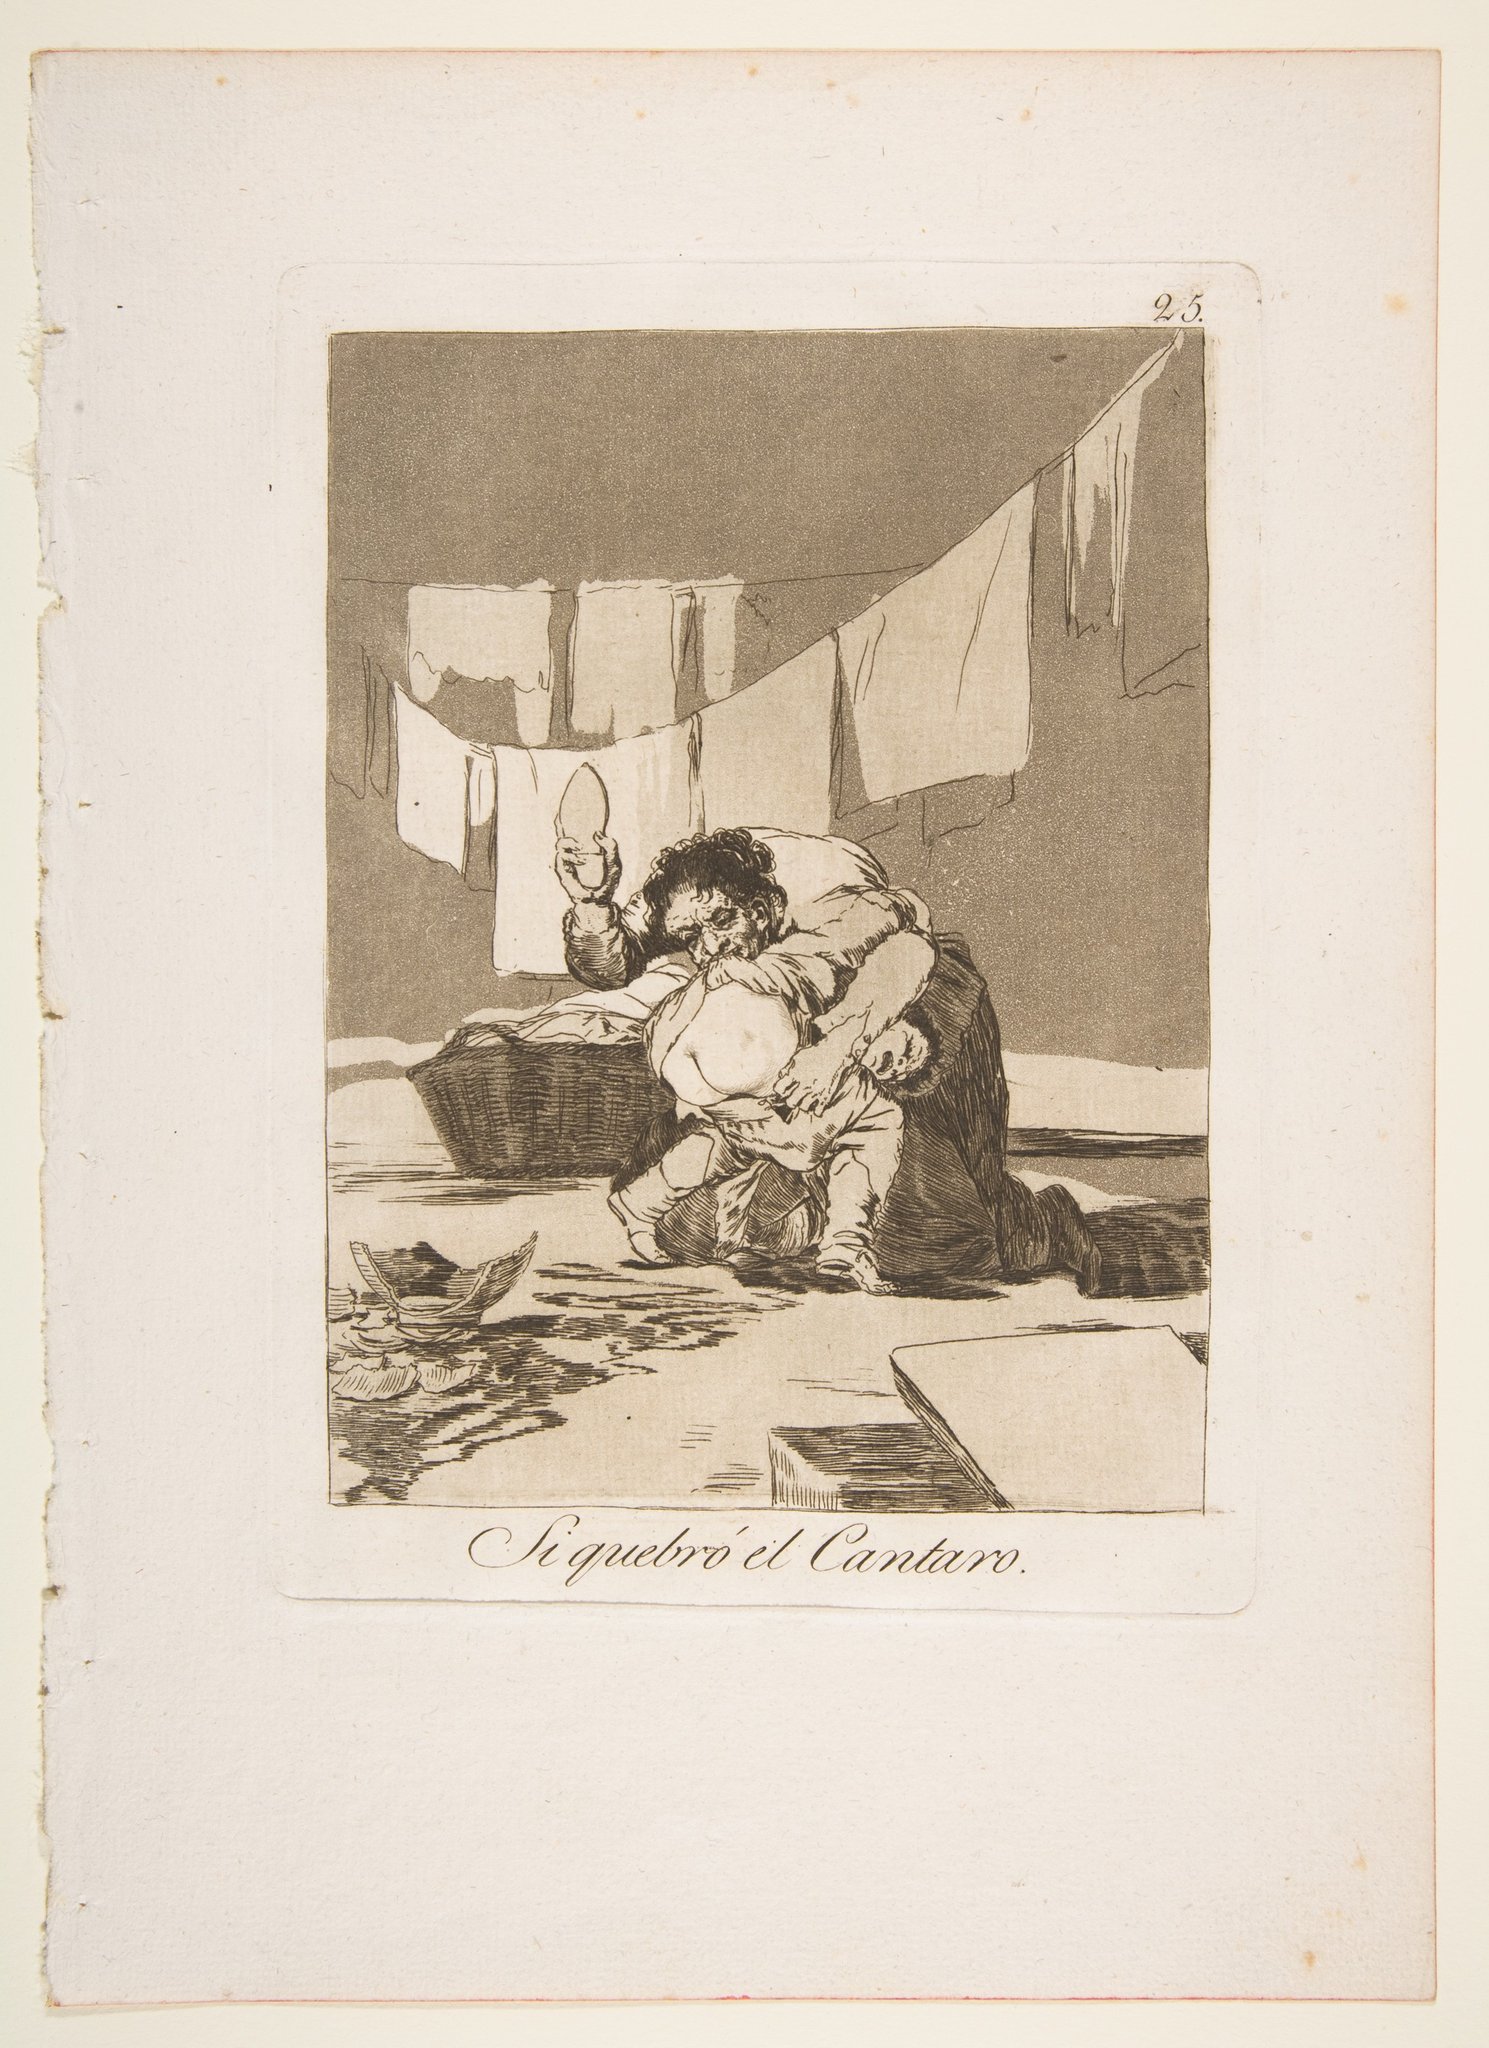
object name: print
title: Plate 25 from "Los Caprichos": If he broke the pot (Si quebró el Cantaro)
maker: goya (francisco de goya y lucientes)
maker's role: artist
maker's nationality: spanish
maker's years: 1746-1828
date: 1799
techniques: aquatint, drypoint, etching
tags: children,men,punishment